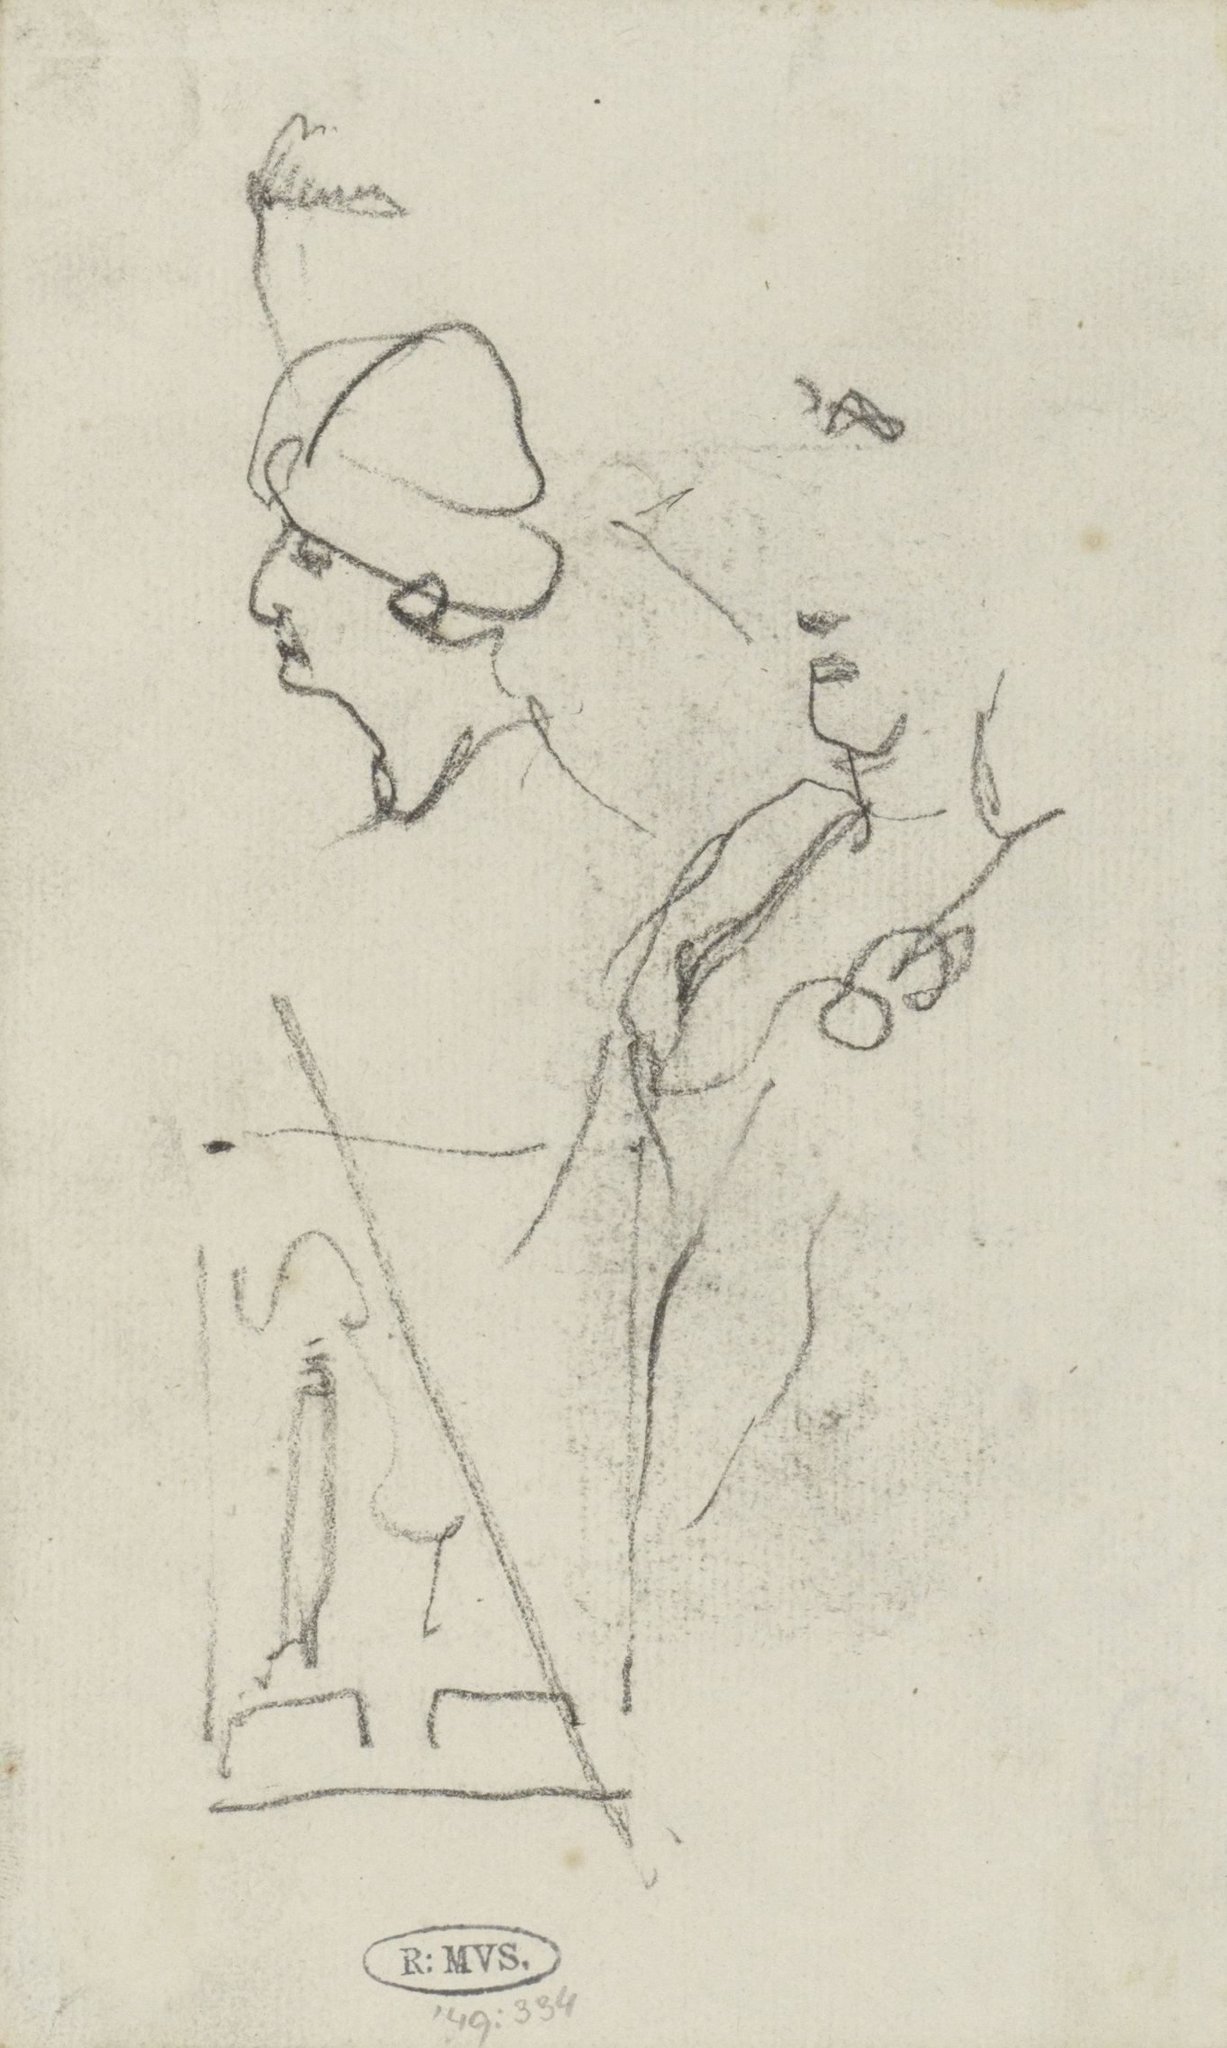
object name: drawing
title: Hoofd en buste van een vrouw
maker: george hendrik breitner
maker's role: draughtsman, painter, print maker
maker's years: 1857-1923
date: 1888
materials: chalk, paper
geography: amsterdam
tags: adult woman, head (human) - aa - female human figure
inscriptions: collector's mark: Lugt 2228